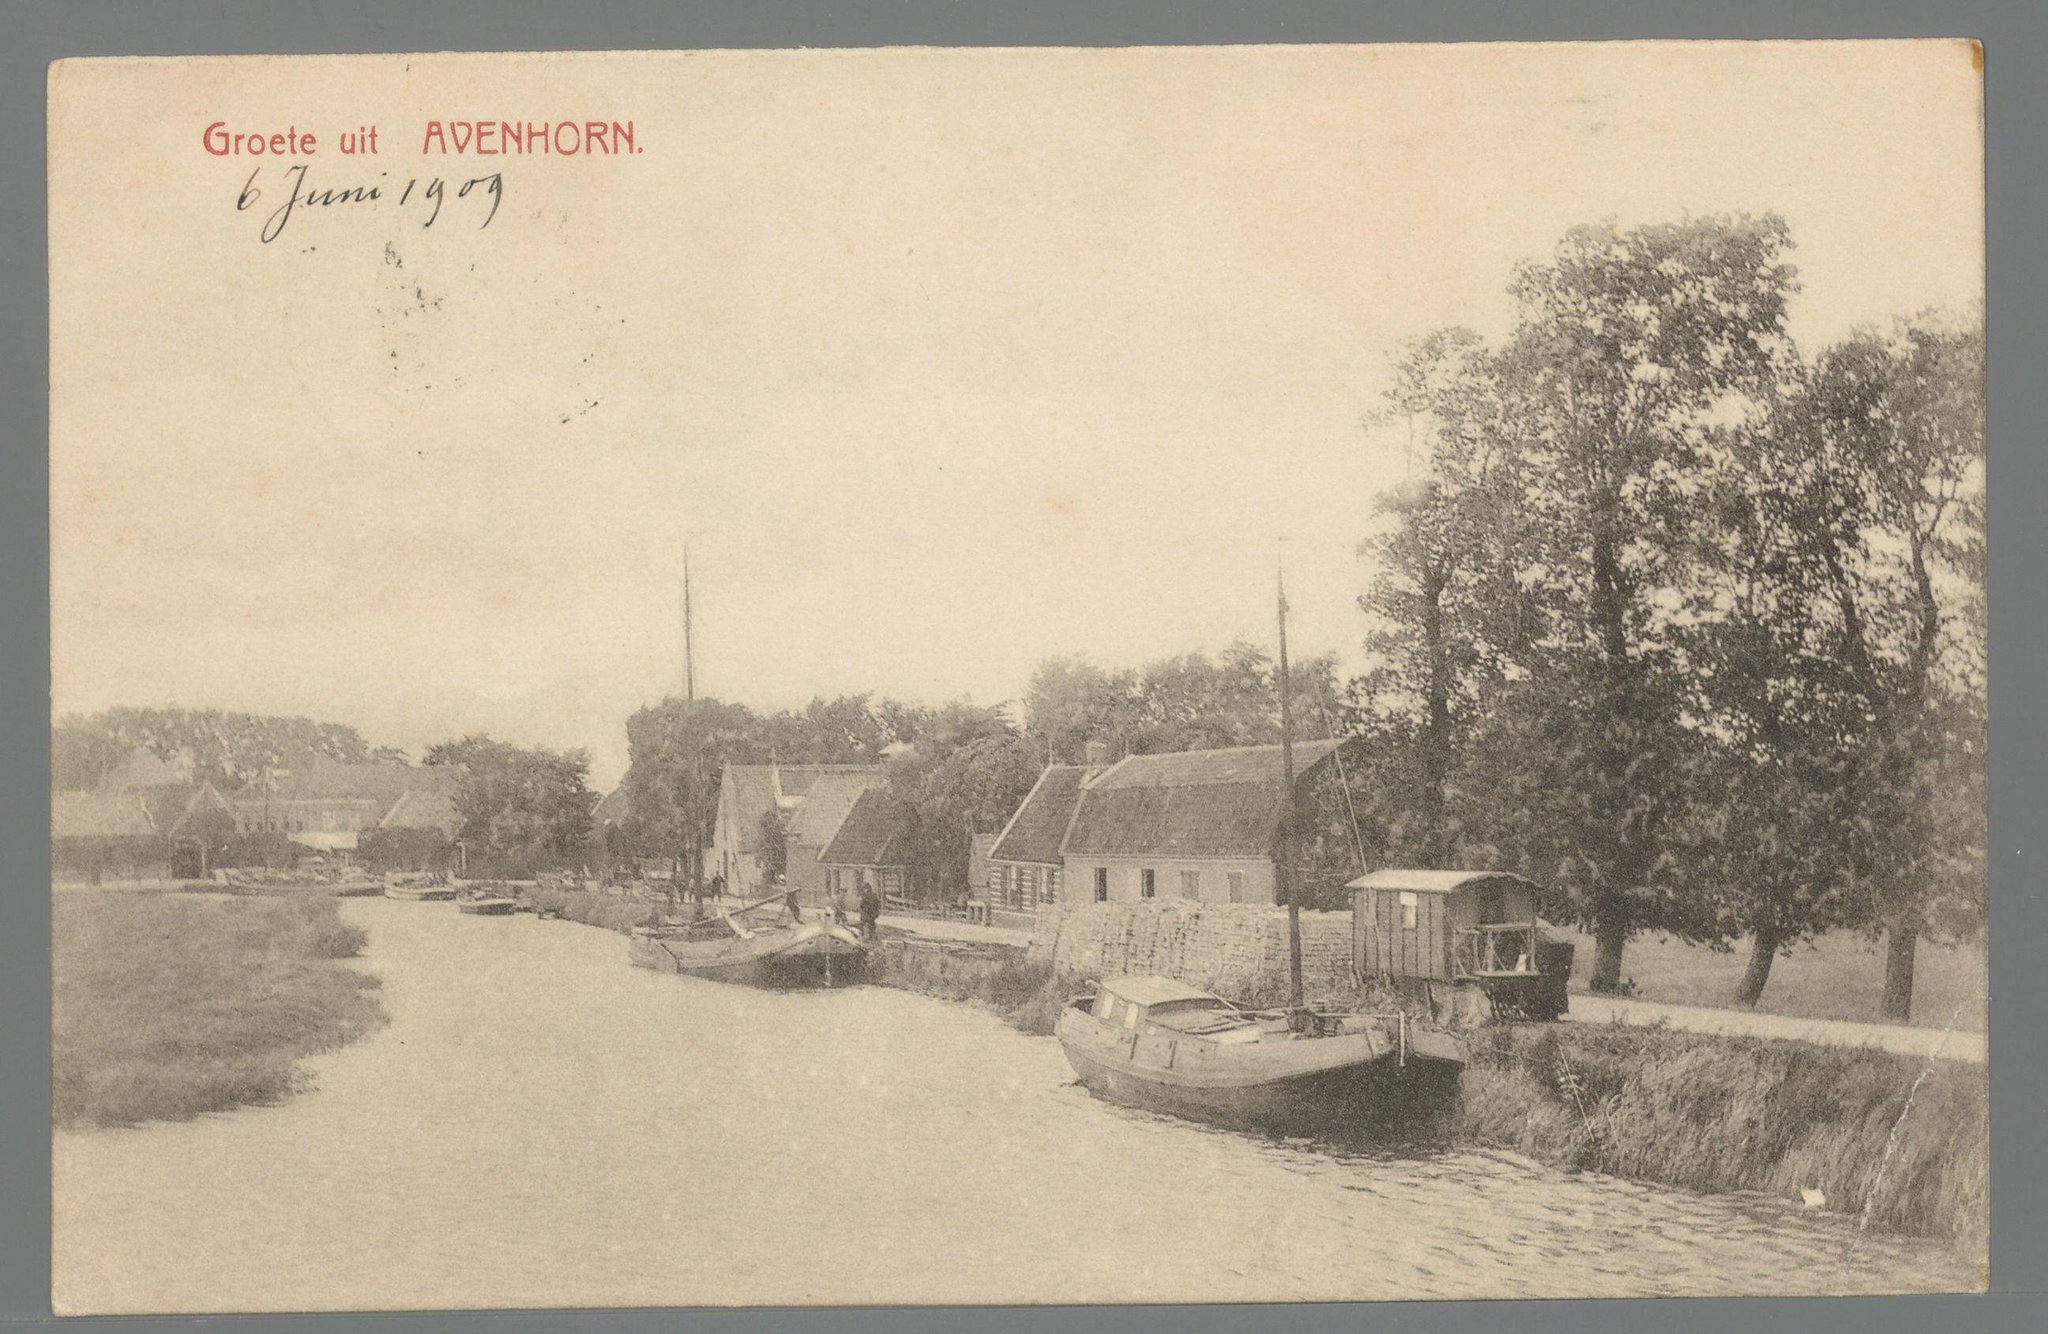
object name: photomechanical print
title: Groete uit Avenhorn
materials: cardboard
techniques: photograph, writing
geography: avenhorn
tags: city-view, and landscape with man-made constructions, canal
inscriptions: postage stamp